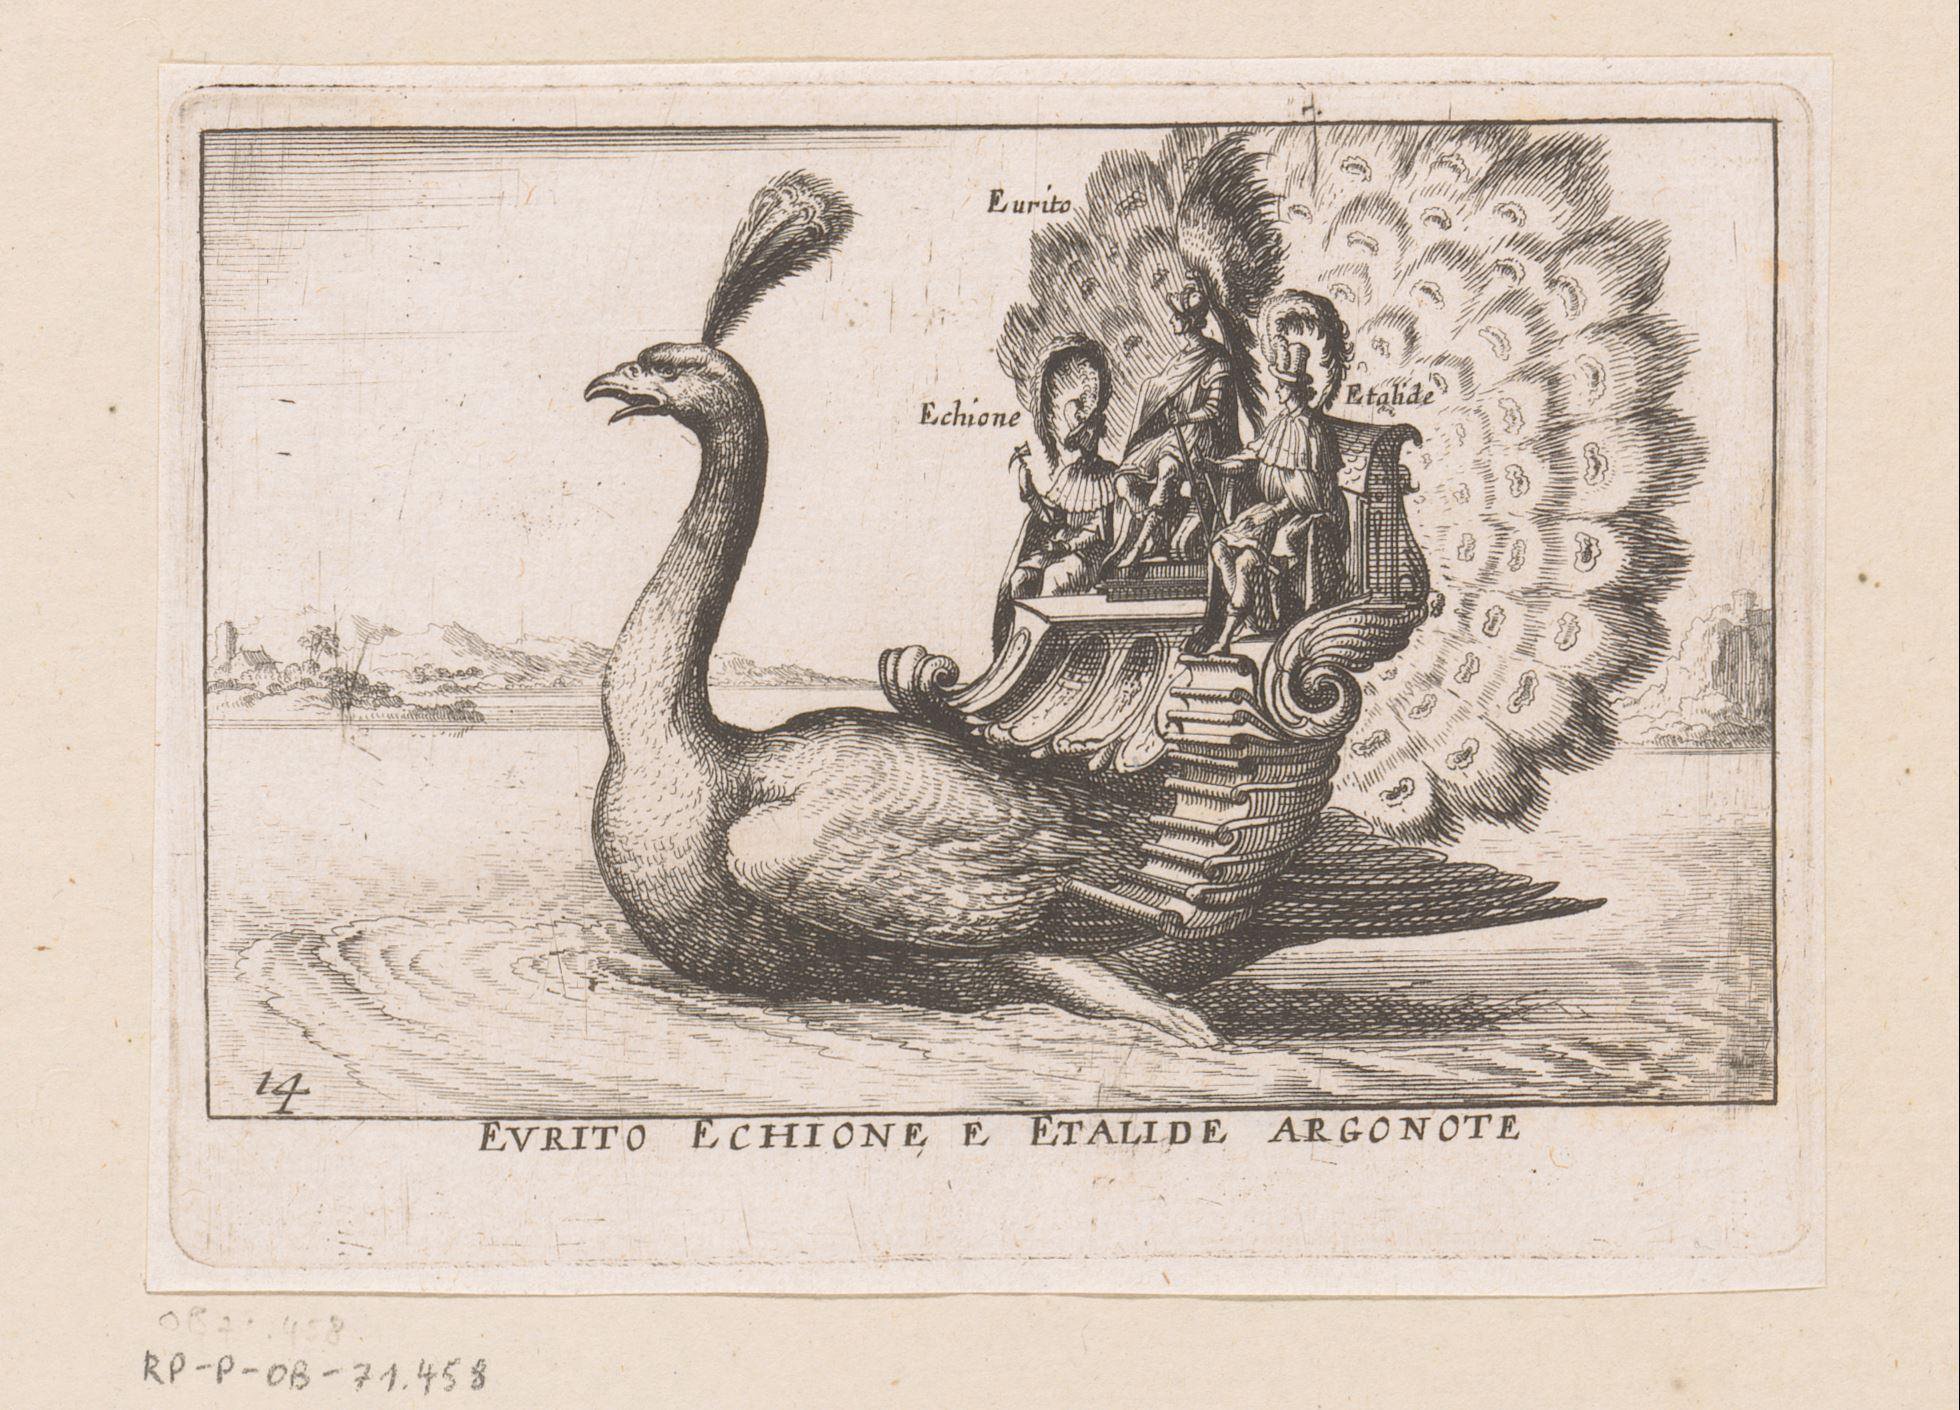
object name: print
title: Schip in de vorm van een pauw met Echion, Eurytus en Aithalides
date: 1635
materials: paper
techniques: etching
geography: paris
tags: ships (in general), ornamental birds: peacock, the story of the argonauts: the quest for the golden fleece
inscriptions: collector's mark: Lugt 240